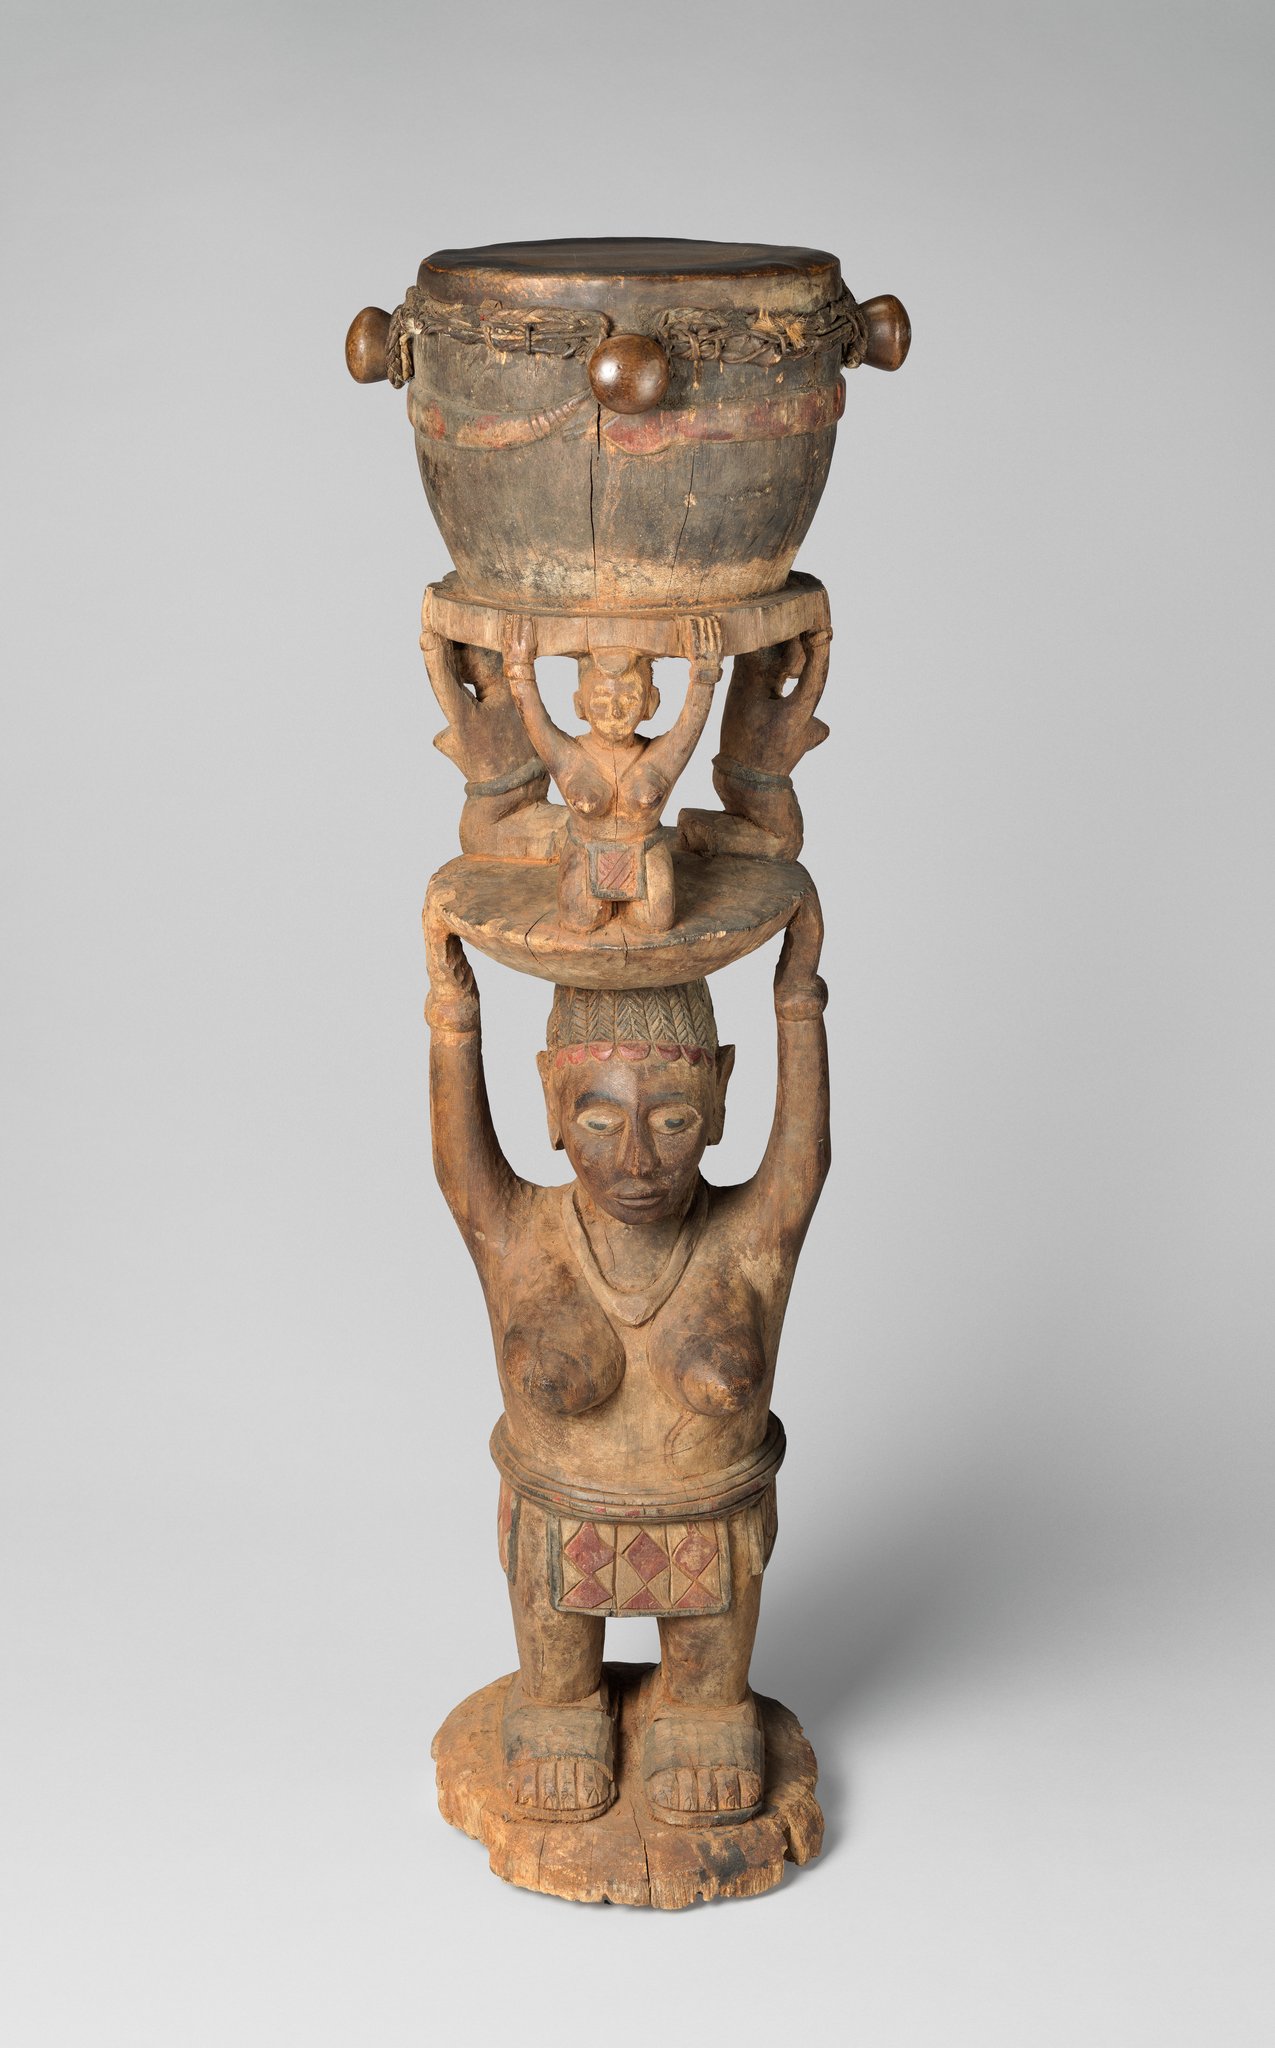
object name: a ndëf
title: A-ndëf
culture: baga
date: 1867-1900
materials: wood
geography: guinea